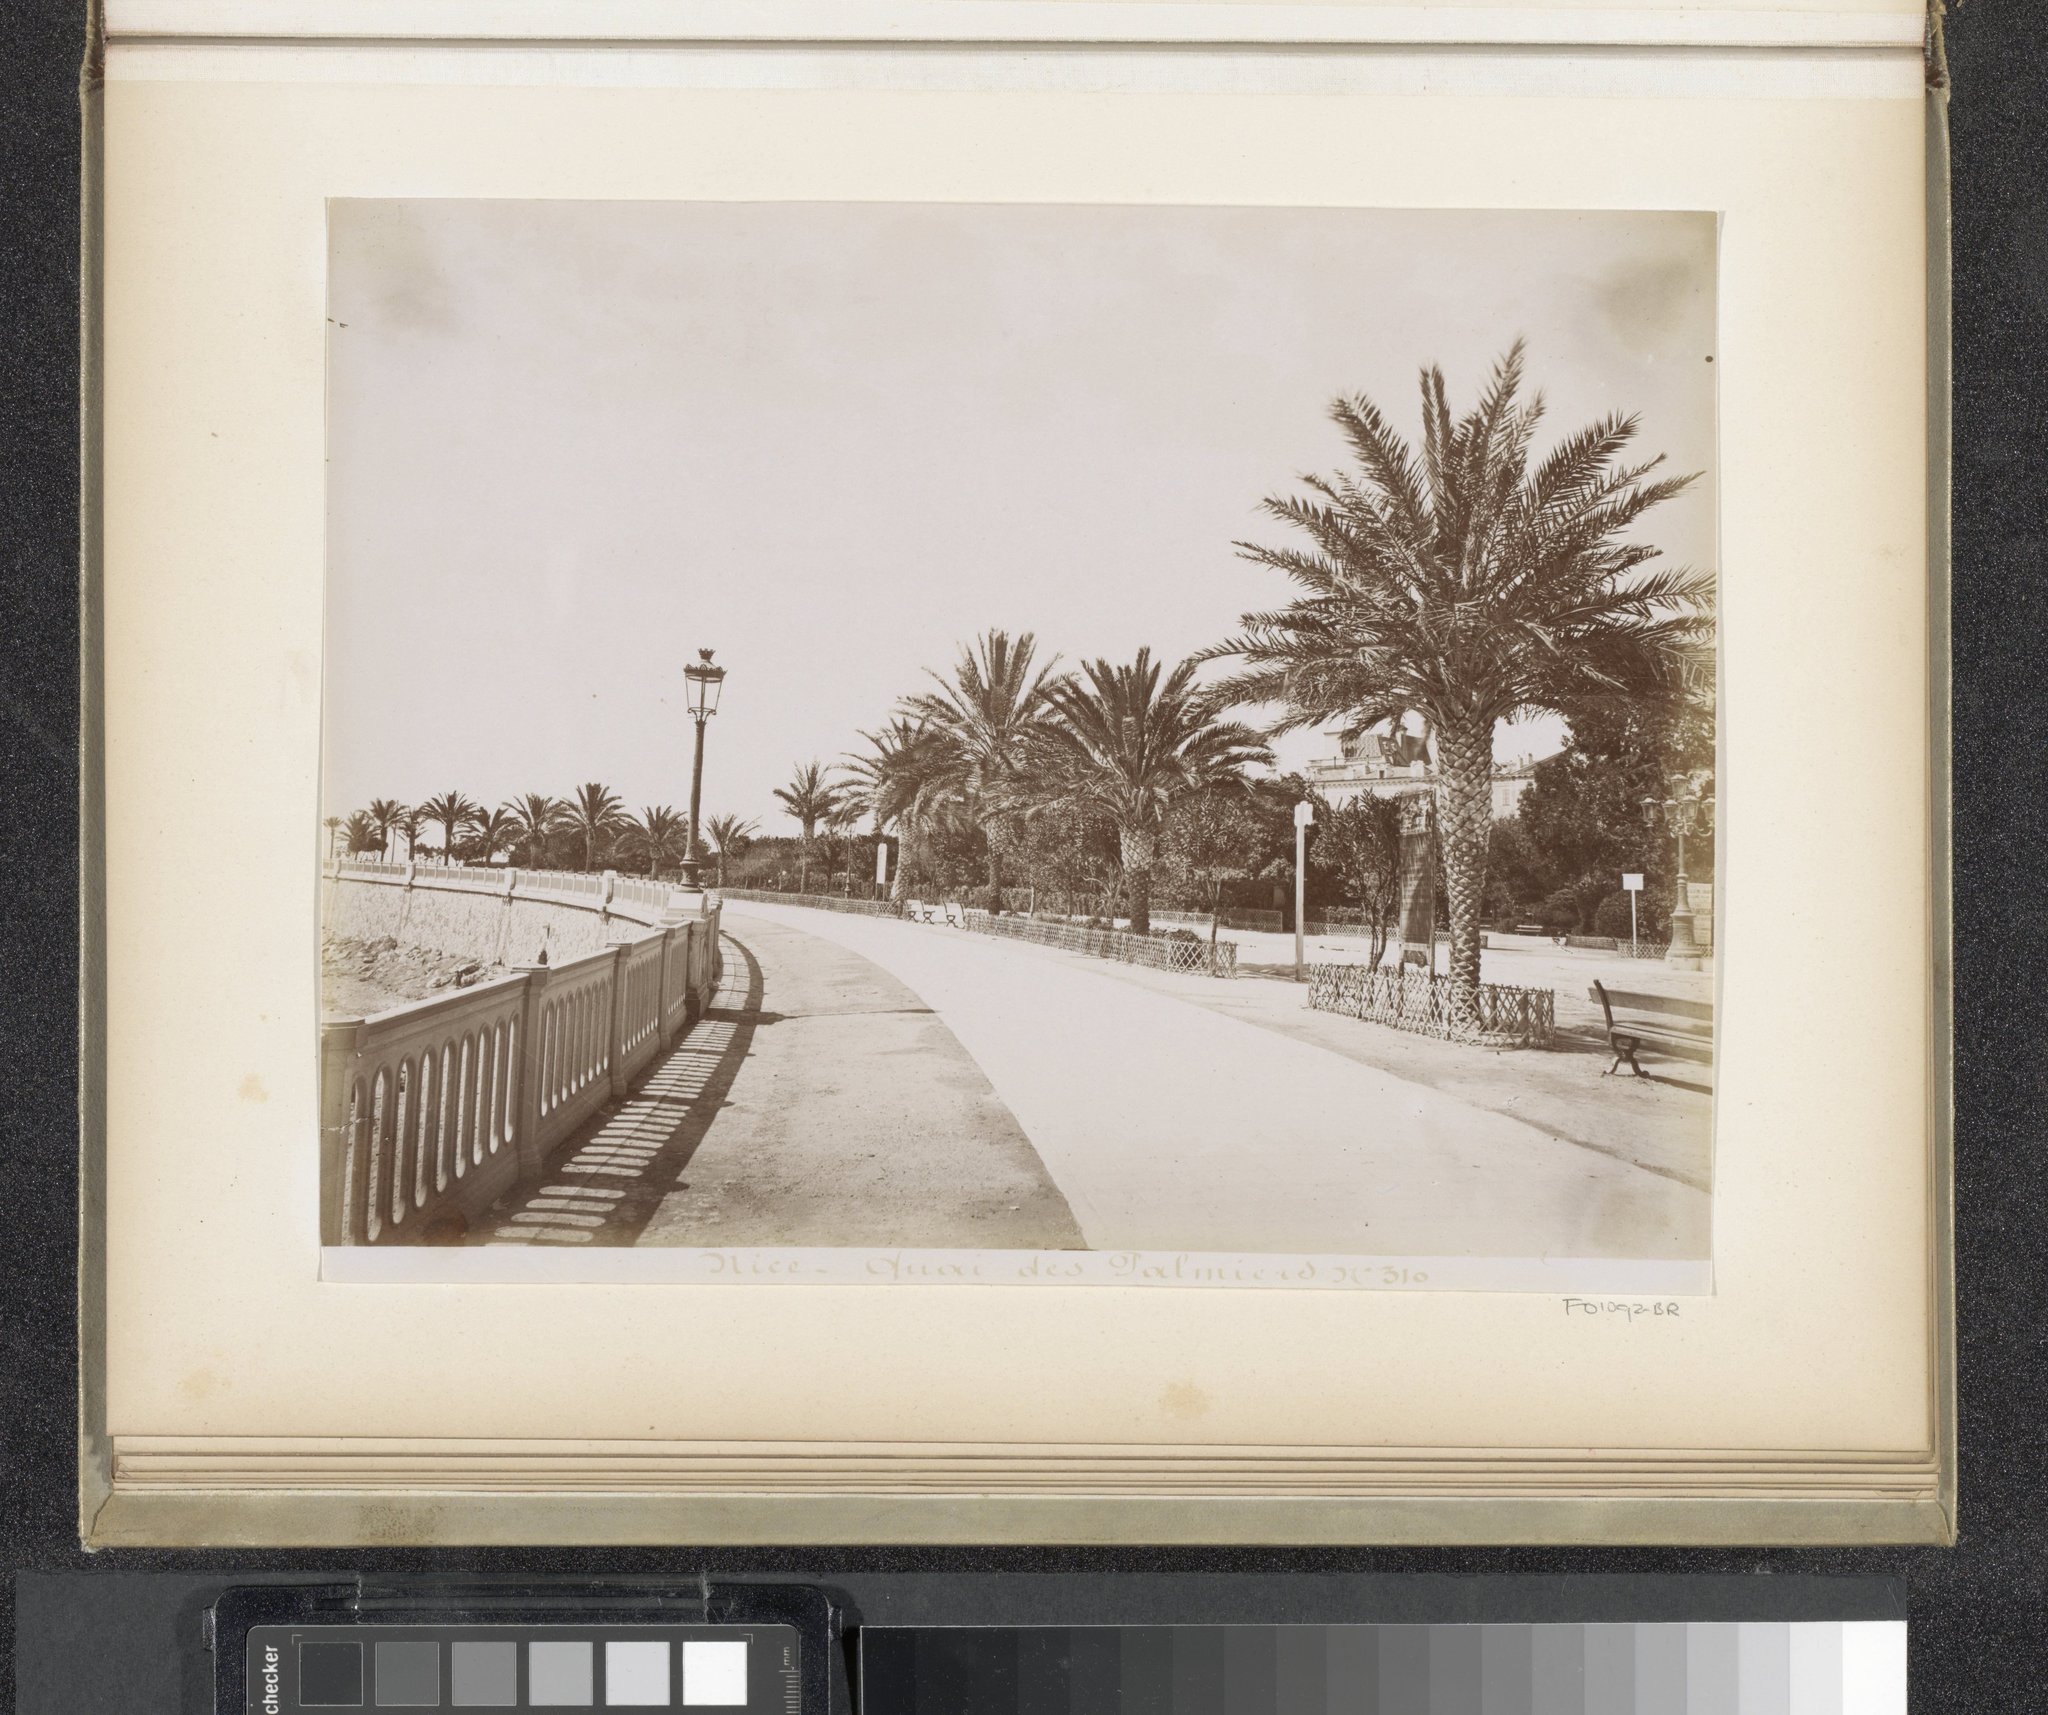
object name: photograph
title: Gezicht op de Quai des Palmiers in Nice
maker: Anonymous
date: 1880-1900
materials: cardboard, paper, photographic support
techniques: albumen print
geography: nice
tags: avenue, boulevard, promenade, esplanade (+ city(-scape) with figures, staffage), trees: palm-tree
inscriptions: negative number: ‘310’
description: Onderdeel van Reisalbum met foto's van bezienswaardigheden in België en Frankrijk.